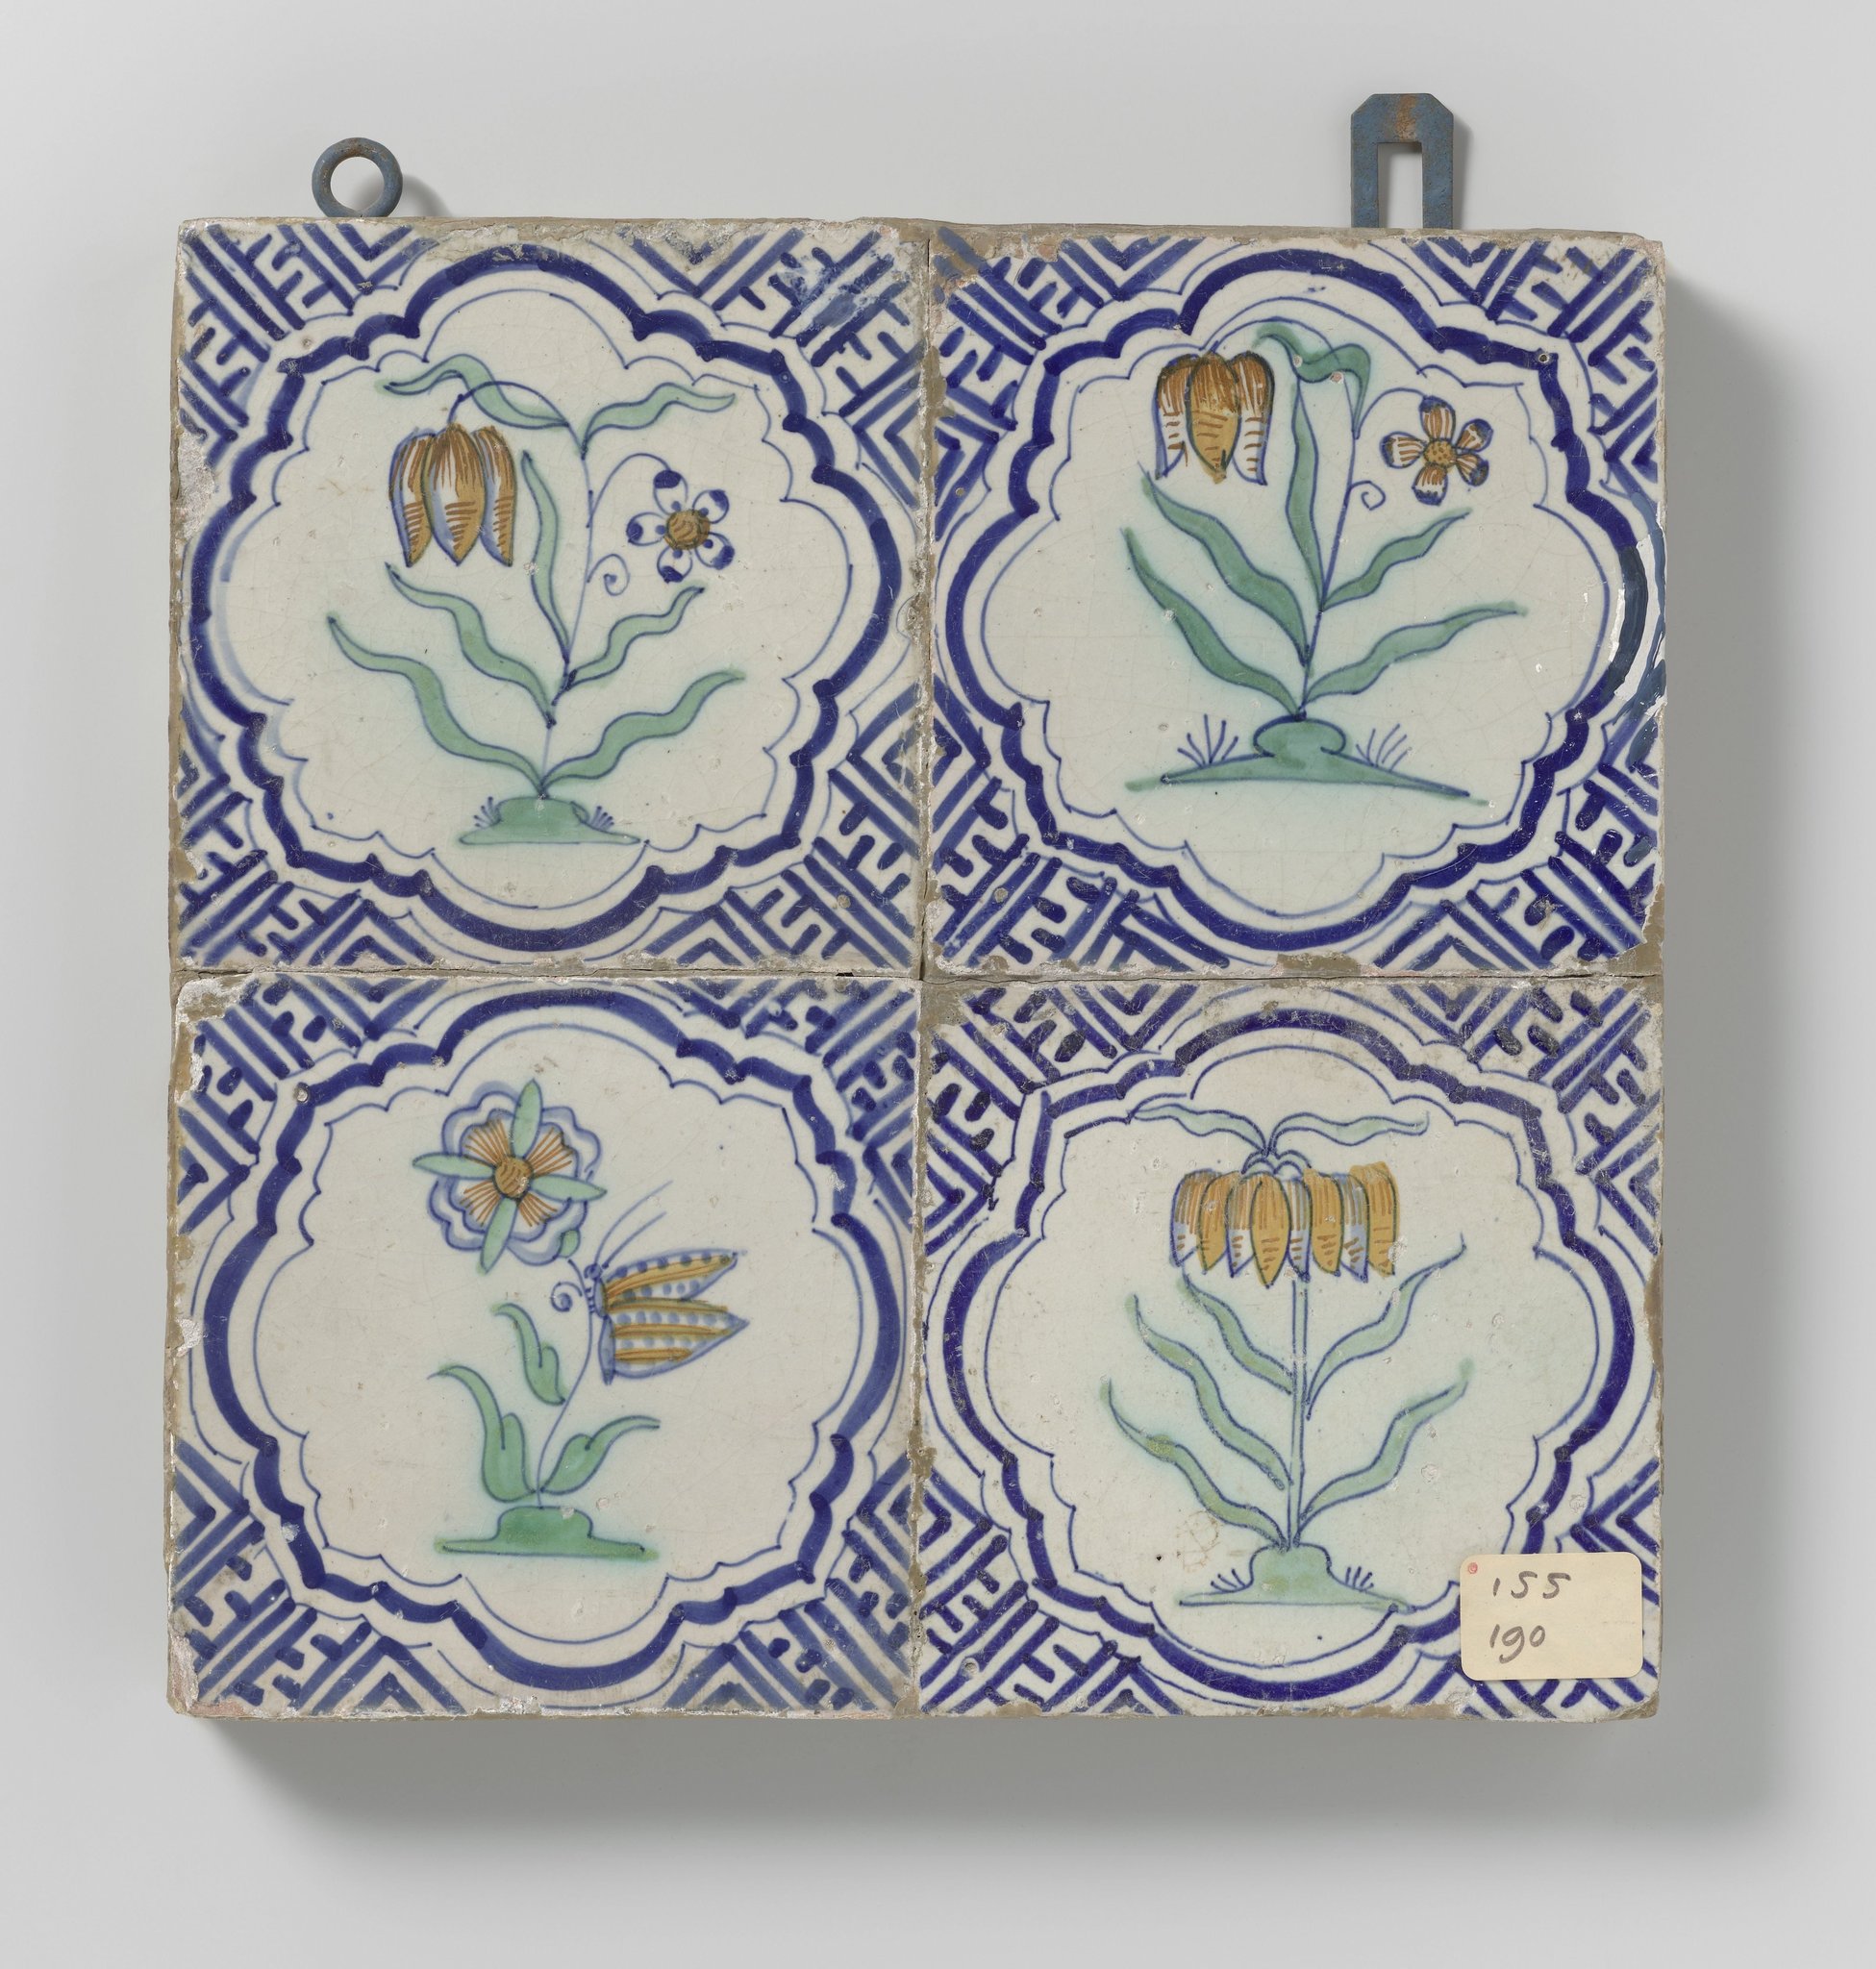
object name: tile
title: Veld van vier tegels met bloemen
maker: Anonymous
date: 1630-1650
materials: earthenware, glaze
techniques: maiolica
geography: netherlands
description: Veld van vier tegels (2 x 2) elk met een veelkleurig (blauw, oranje, groen en geel) geschilderde bloem op een grond binnen een cirkel met geschulpte rand. In de hoeken, meander ornament.